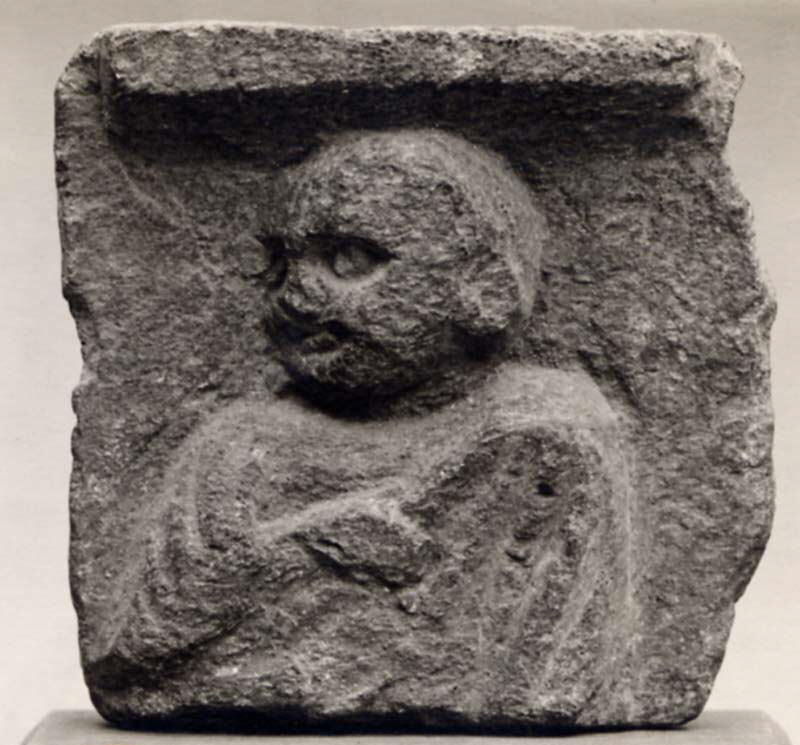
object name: relief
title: Head of a Male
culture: gandhara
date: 1-200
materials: stone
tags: gandhara